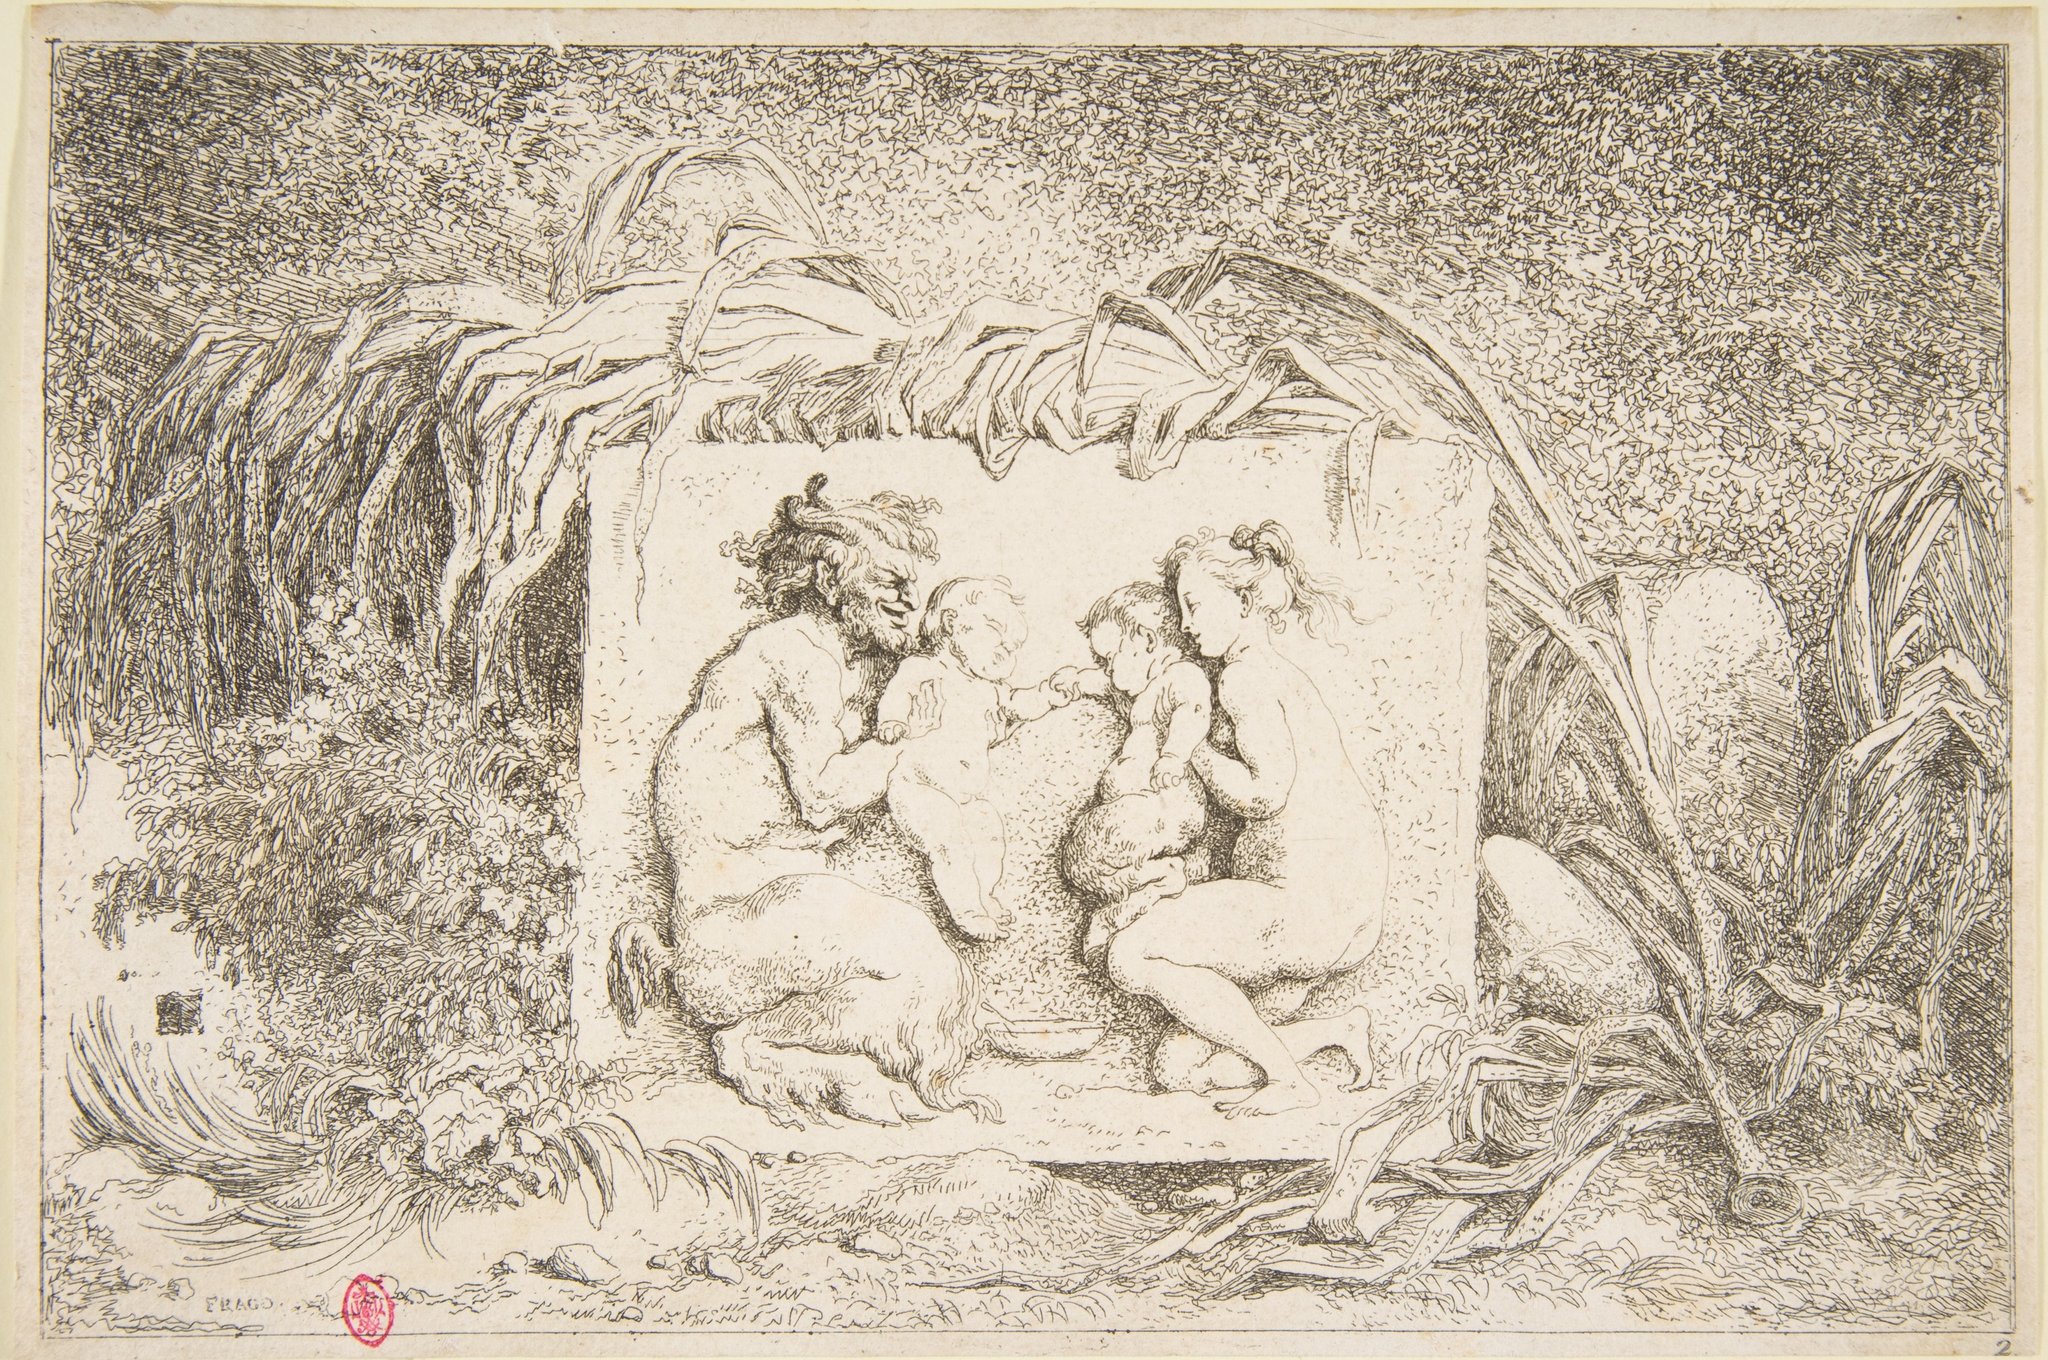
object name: print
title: Bacchanale - Satyr and Nymph with Infant and Infant Satyr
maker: jean honoré fragonard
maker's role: artist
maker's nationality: french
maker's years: 1732-1806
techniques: etching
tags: infants,nymphs,satyrs